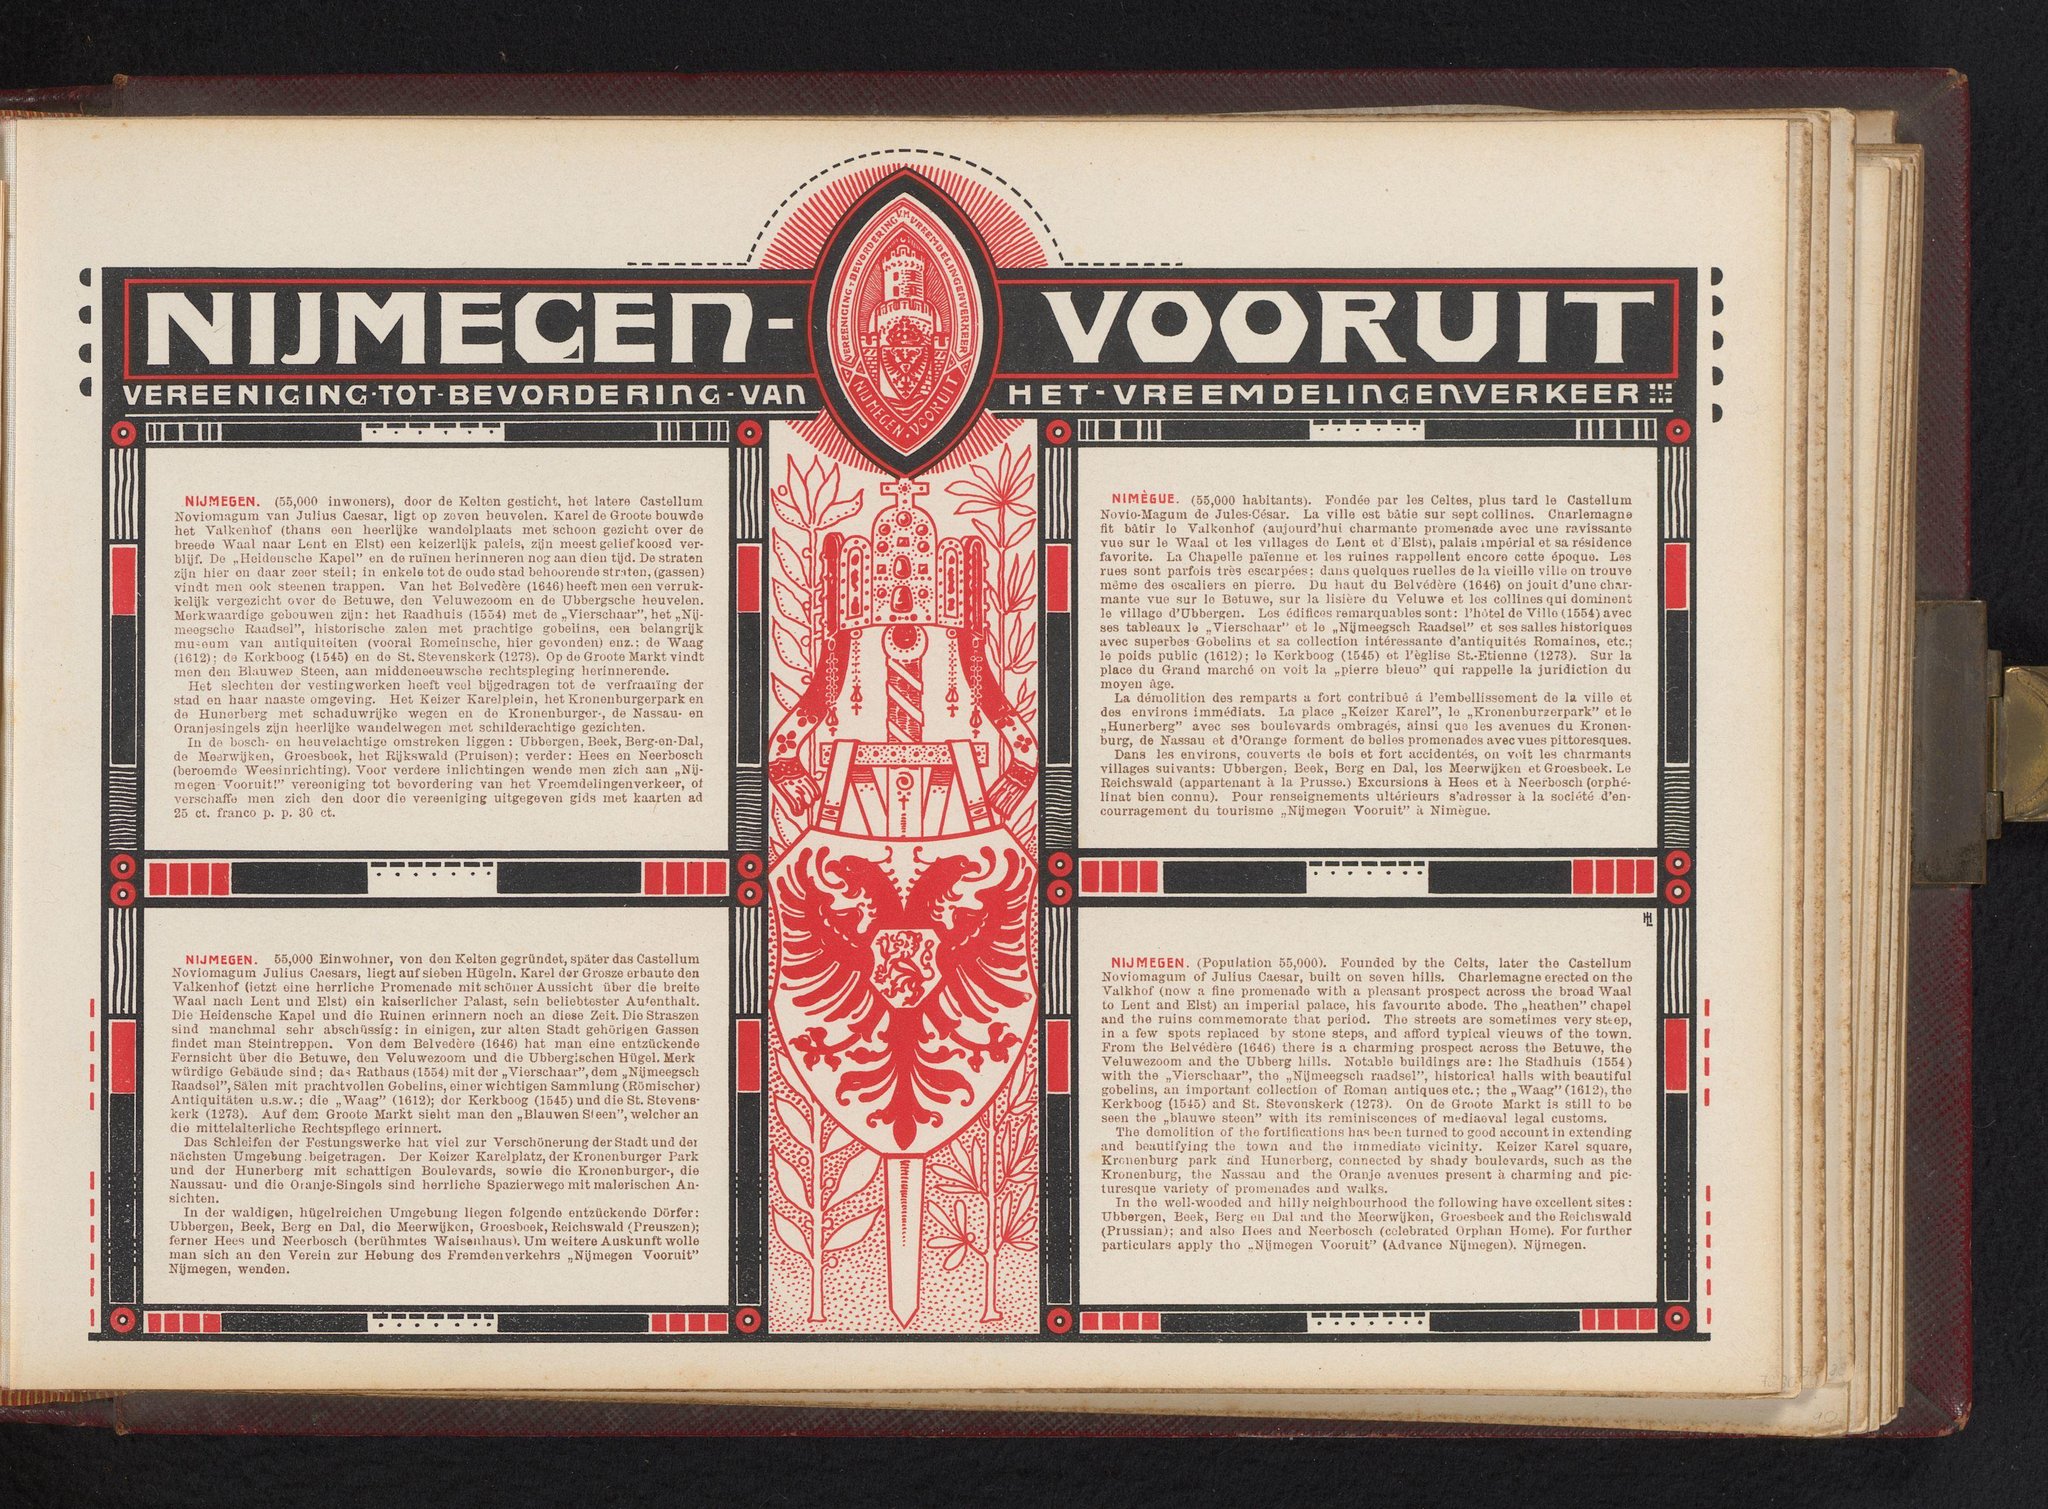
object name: album leaf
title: Advertentie van Nijmegen Vooruit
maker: Anonymous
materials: paper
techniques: lithograph, printing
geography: netherlands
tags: coat of arms (as symbol of the state, etc.), advertising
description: Advertentie van Nijmegen Vooruit, Vereeniging van het Vreemdelingenverkeer, in vier talen. Deze pagina maakt deel uit van een album.